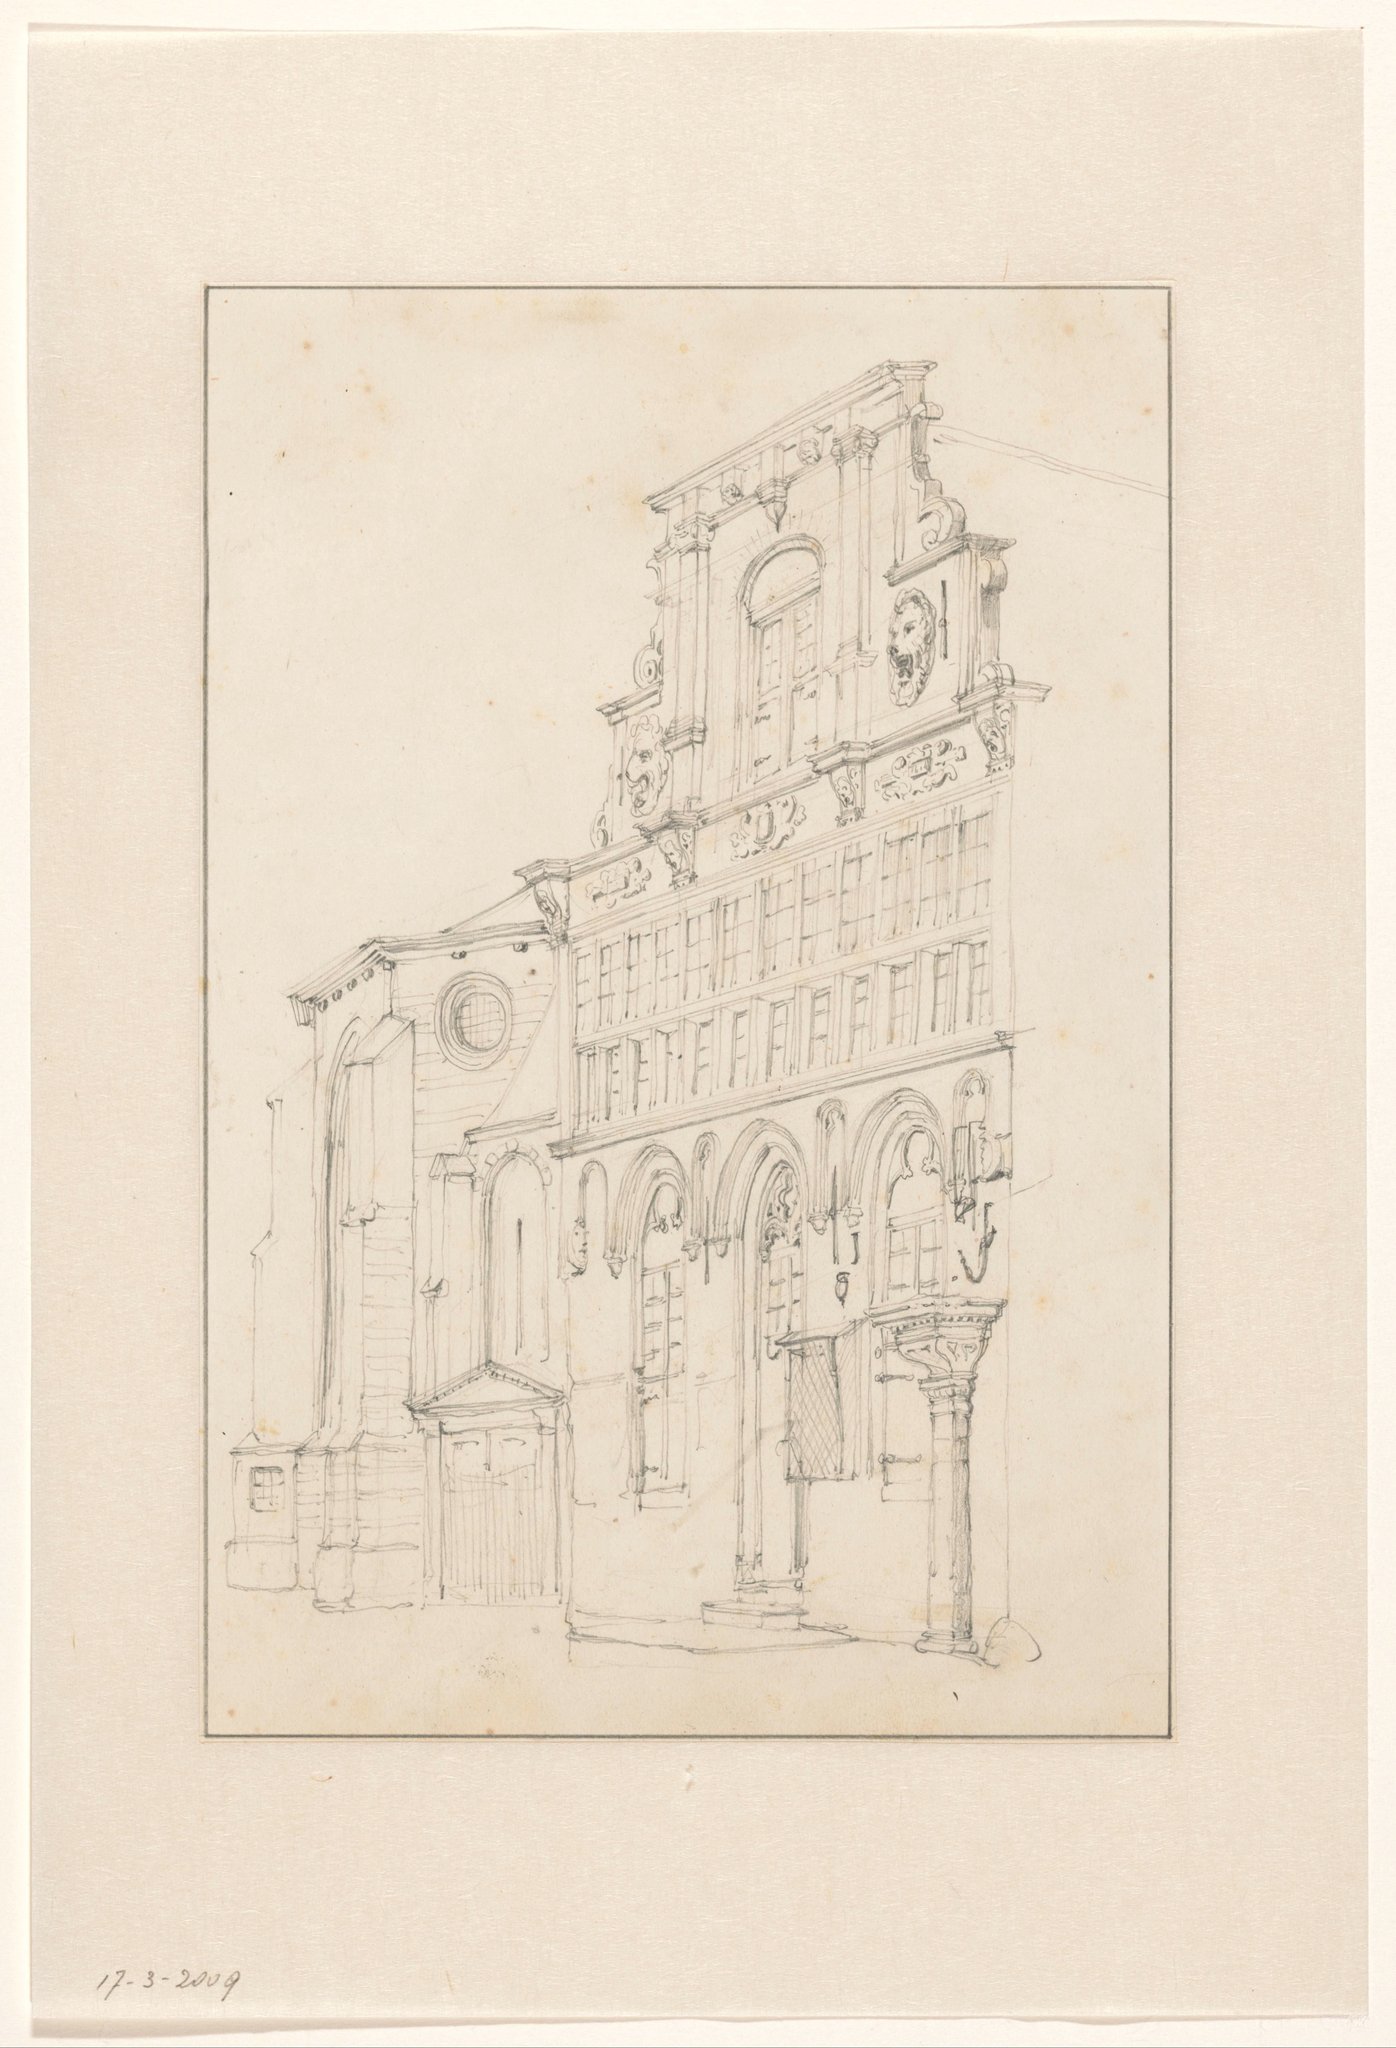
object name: drawing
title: Façade van het raadhuis te Woerden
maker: cornelis springer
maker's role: draughtsman, painter, print maker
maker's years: 1817-1891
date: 1827-1891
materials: paper, pencil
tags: townhall